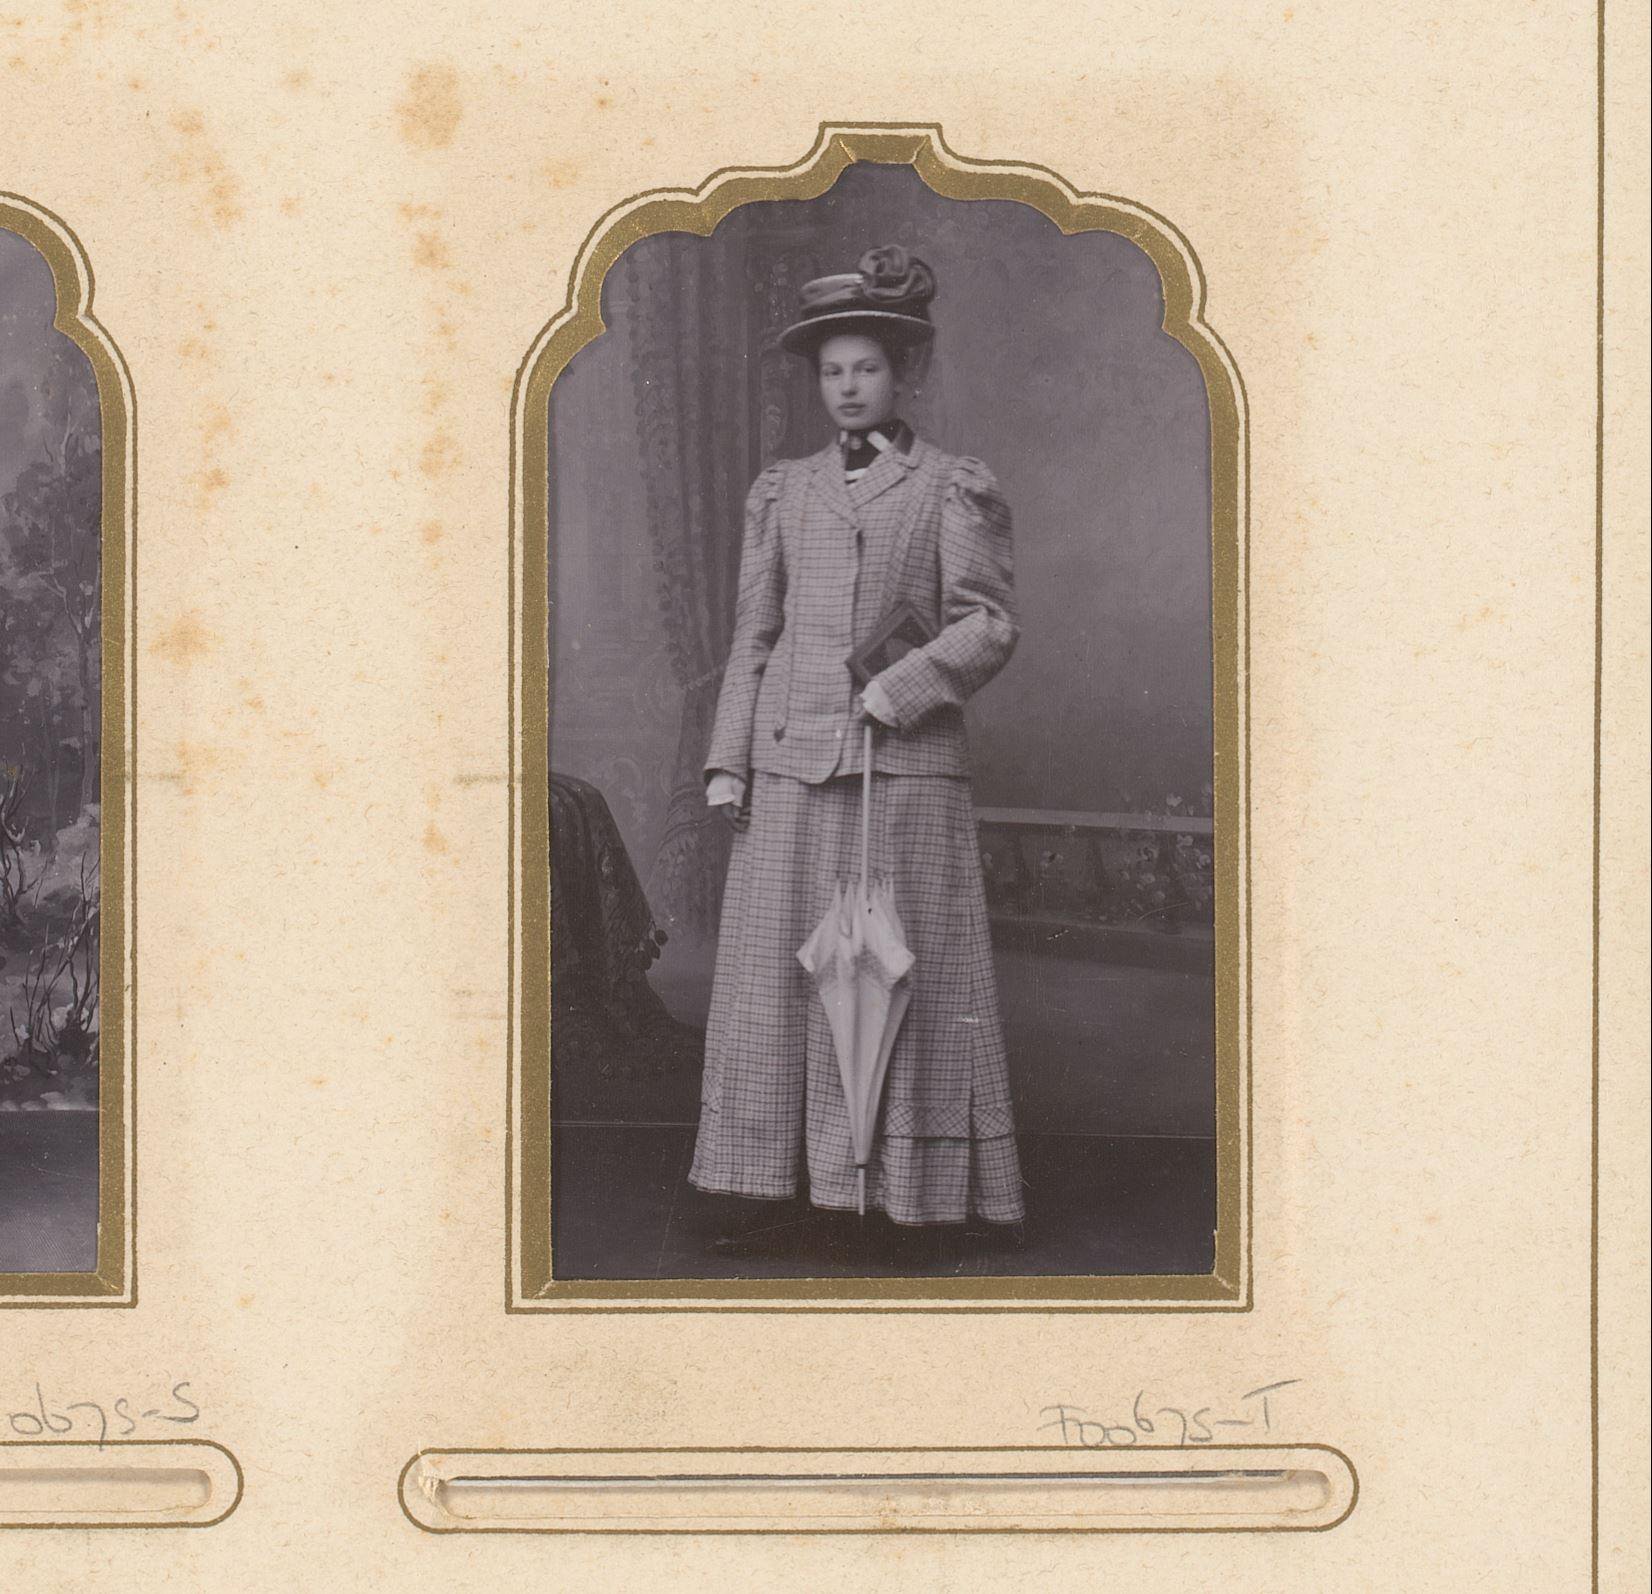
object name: photograph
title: Portret van een staande vrouw met hoed en paraplu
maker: leonardus pieter tismeer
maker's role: fotograaf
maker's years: 1874-1961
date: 1894-1920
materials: cardboard, photographic support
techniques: collodion silver print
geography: ijmuiden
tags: historical persons - bb - woman, head-gear: cap, umbrella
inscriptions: inscription: ‘Leo P. Tismeer/ Ymuiden (...)’